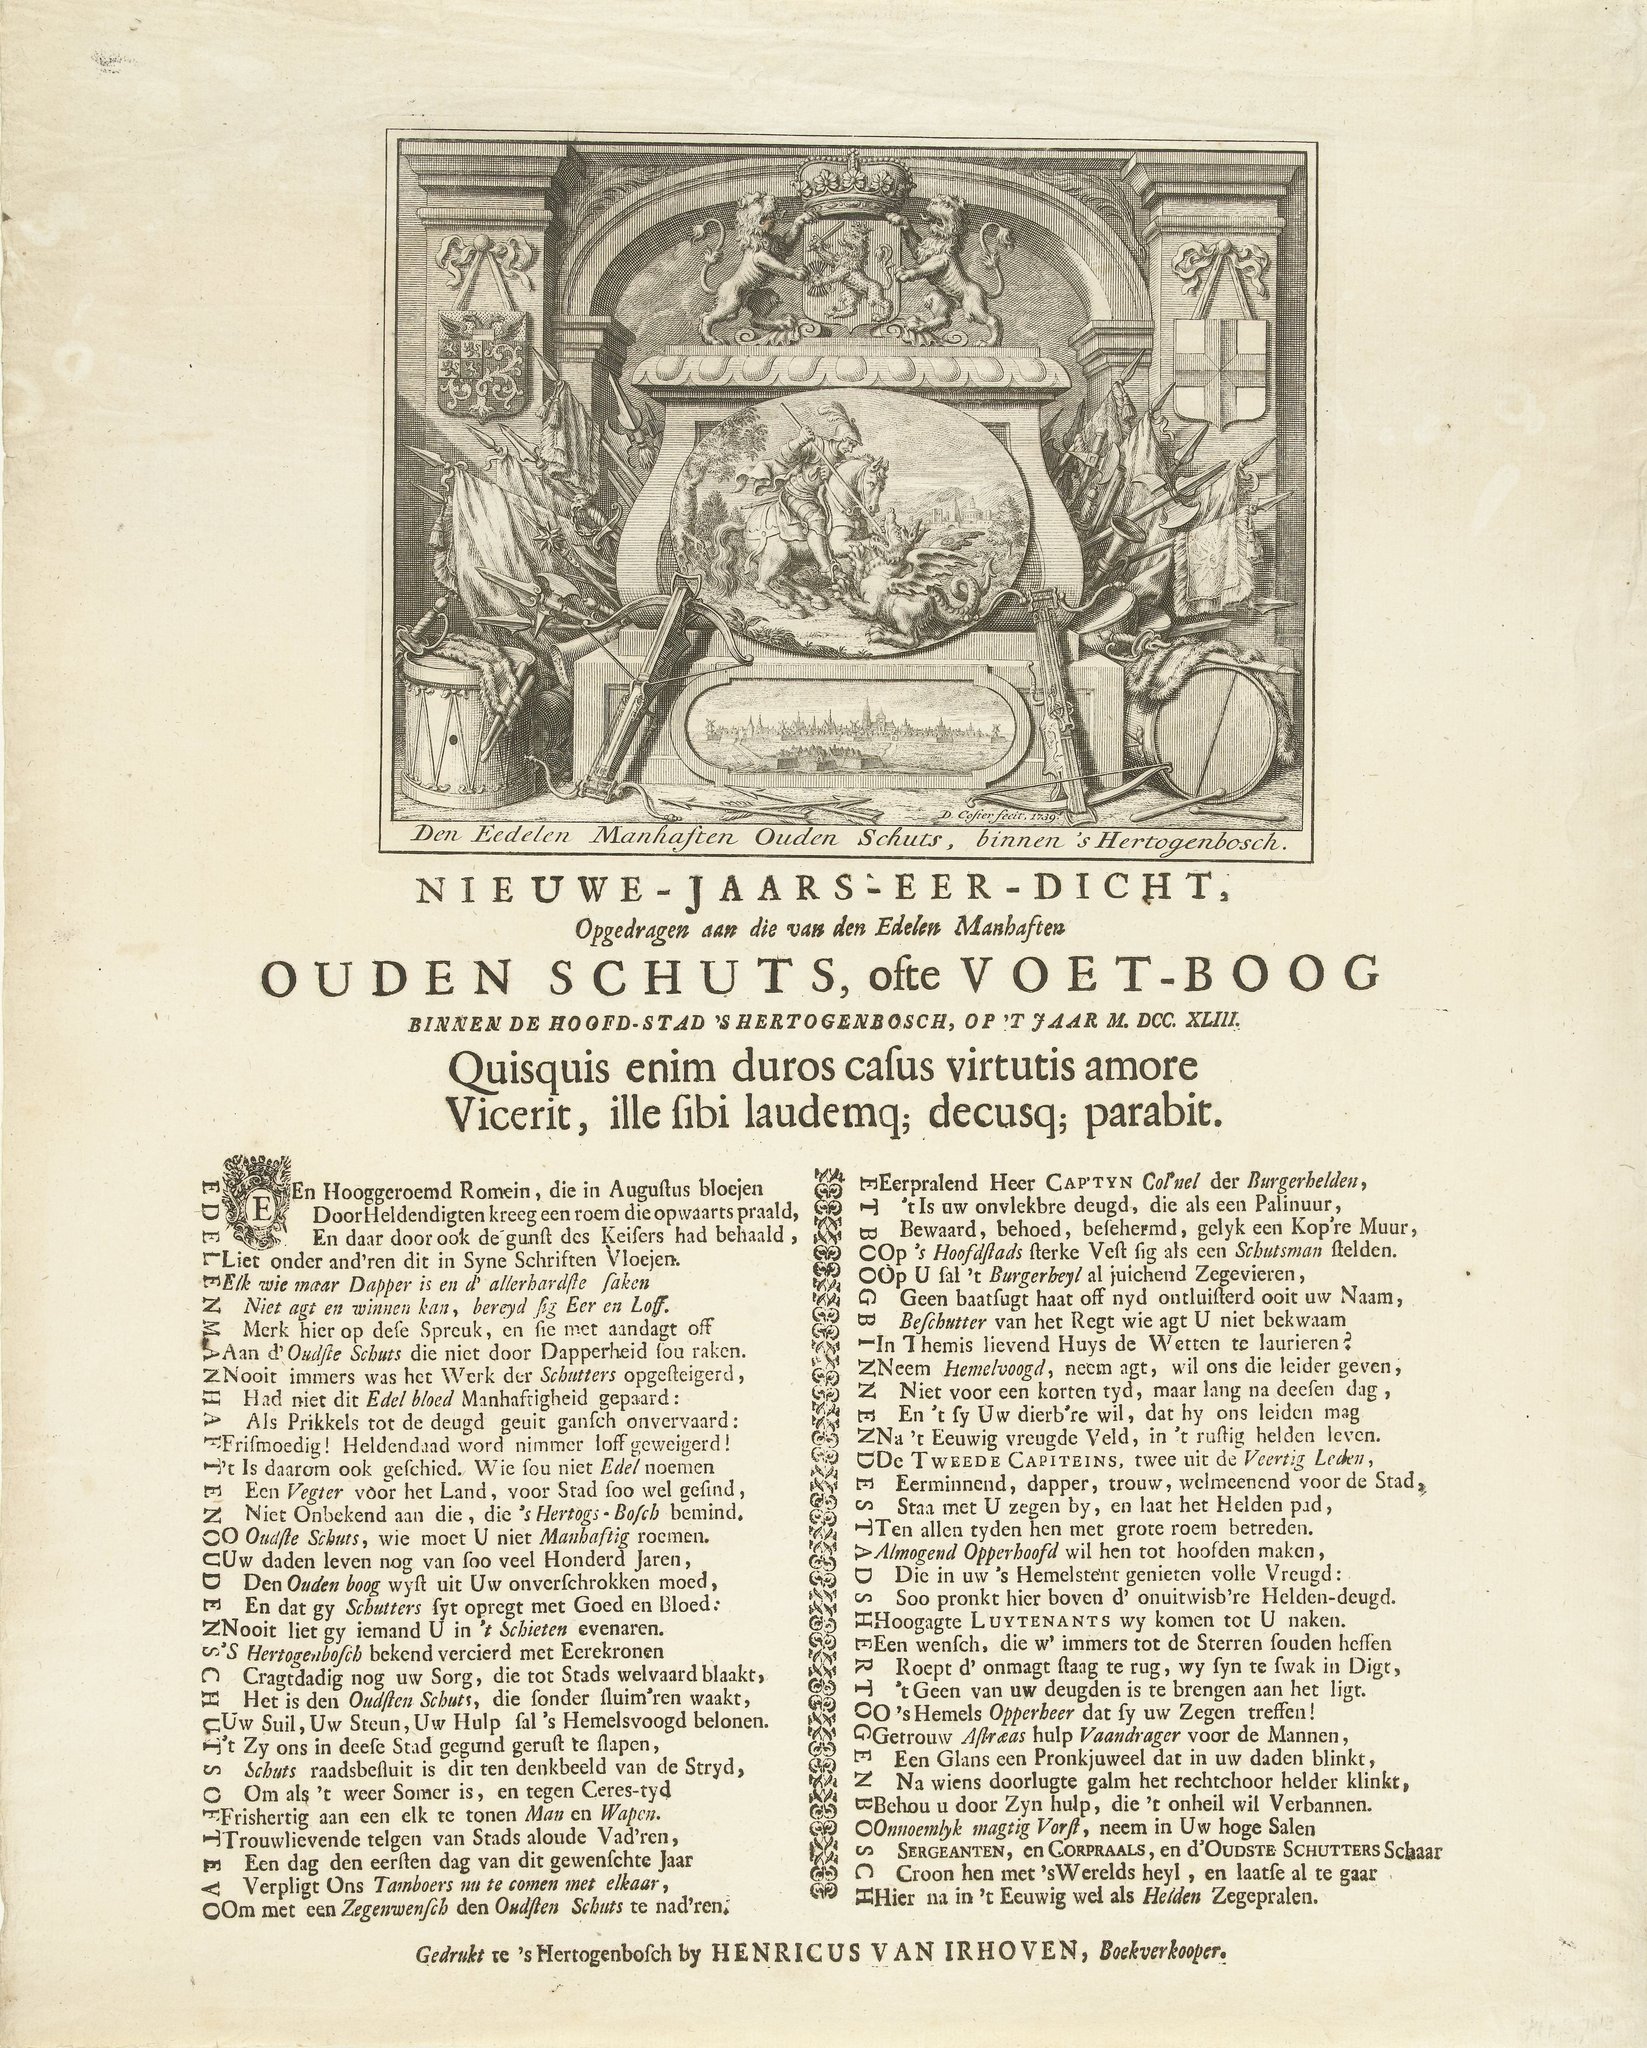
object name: print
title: Nieuwe-Jaars-Eer-Dicht, Opgedragen aan die van den Edelen Manhaften Ouden Schuts, ofte Voet-boog Binnen de Hoofd-stad s'Hertogenbosch, op 't Jaar MDCCXLIII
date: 1739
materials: paper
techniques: engraving, etching, letterpress printing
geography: den bosch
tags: warfare; military affairs (+ citizen soldiery, civil guard, citizen militia), the warrior martyr george (georgius); possible attributes: banner (red cross on white field), (red) cross, dragon, (white) horse, broken lance, shield (with cross), sword, den bosch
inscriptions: collector's mark: Lugt 2228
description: Nieuwjaarsprent van de schutterij De Oude Schuts of Voetboogdoelen van de stad 's-Hertogenbosch voor het jaar 1743. Embleem met Sint Joris die de draak doodt boven een gezicht op Den Bosch, links en rechts wapens, vaandels en de wapena van Den Bosch en Sint-Joris. Op het blad onder de plaat een vers in twee kolommen.